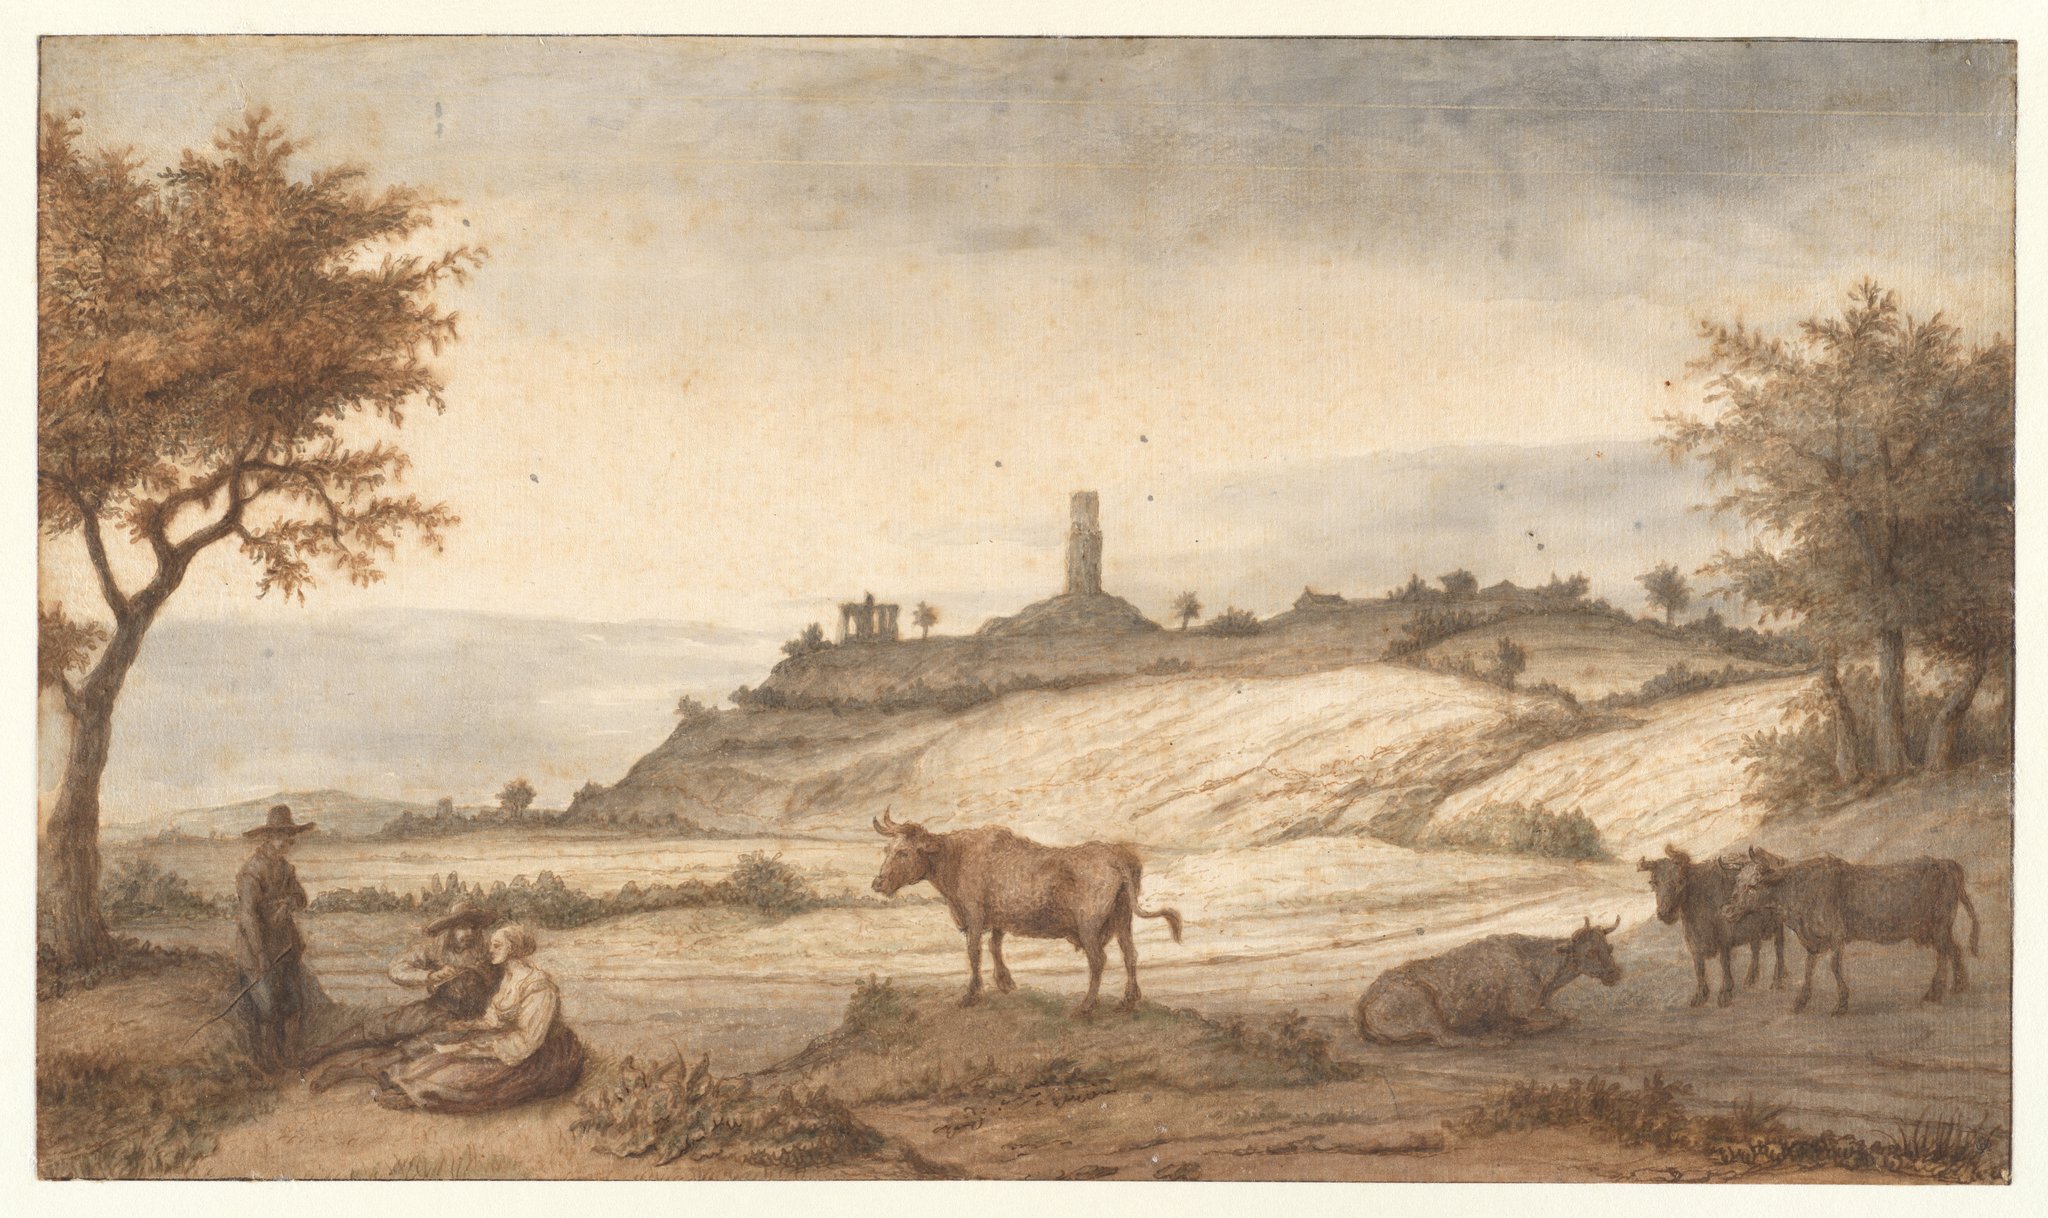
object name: drawing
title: The Monterberg Seen from Kalkar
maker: lambert doomer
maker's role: artist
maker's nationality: dutch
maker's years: 1624-1700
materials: ink, paper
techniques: brush, pen, printing, wash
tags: cows,landscapes